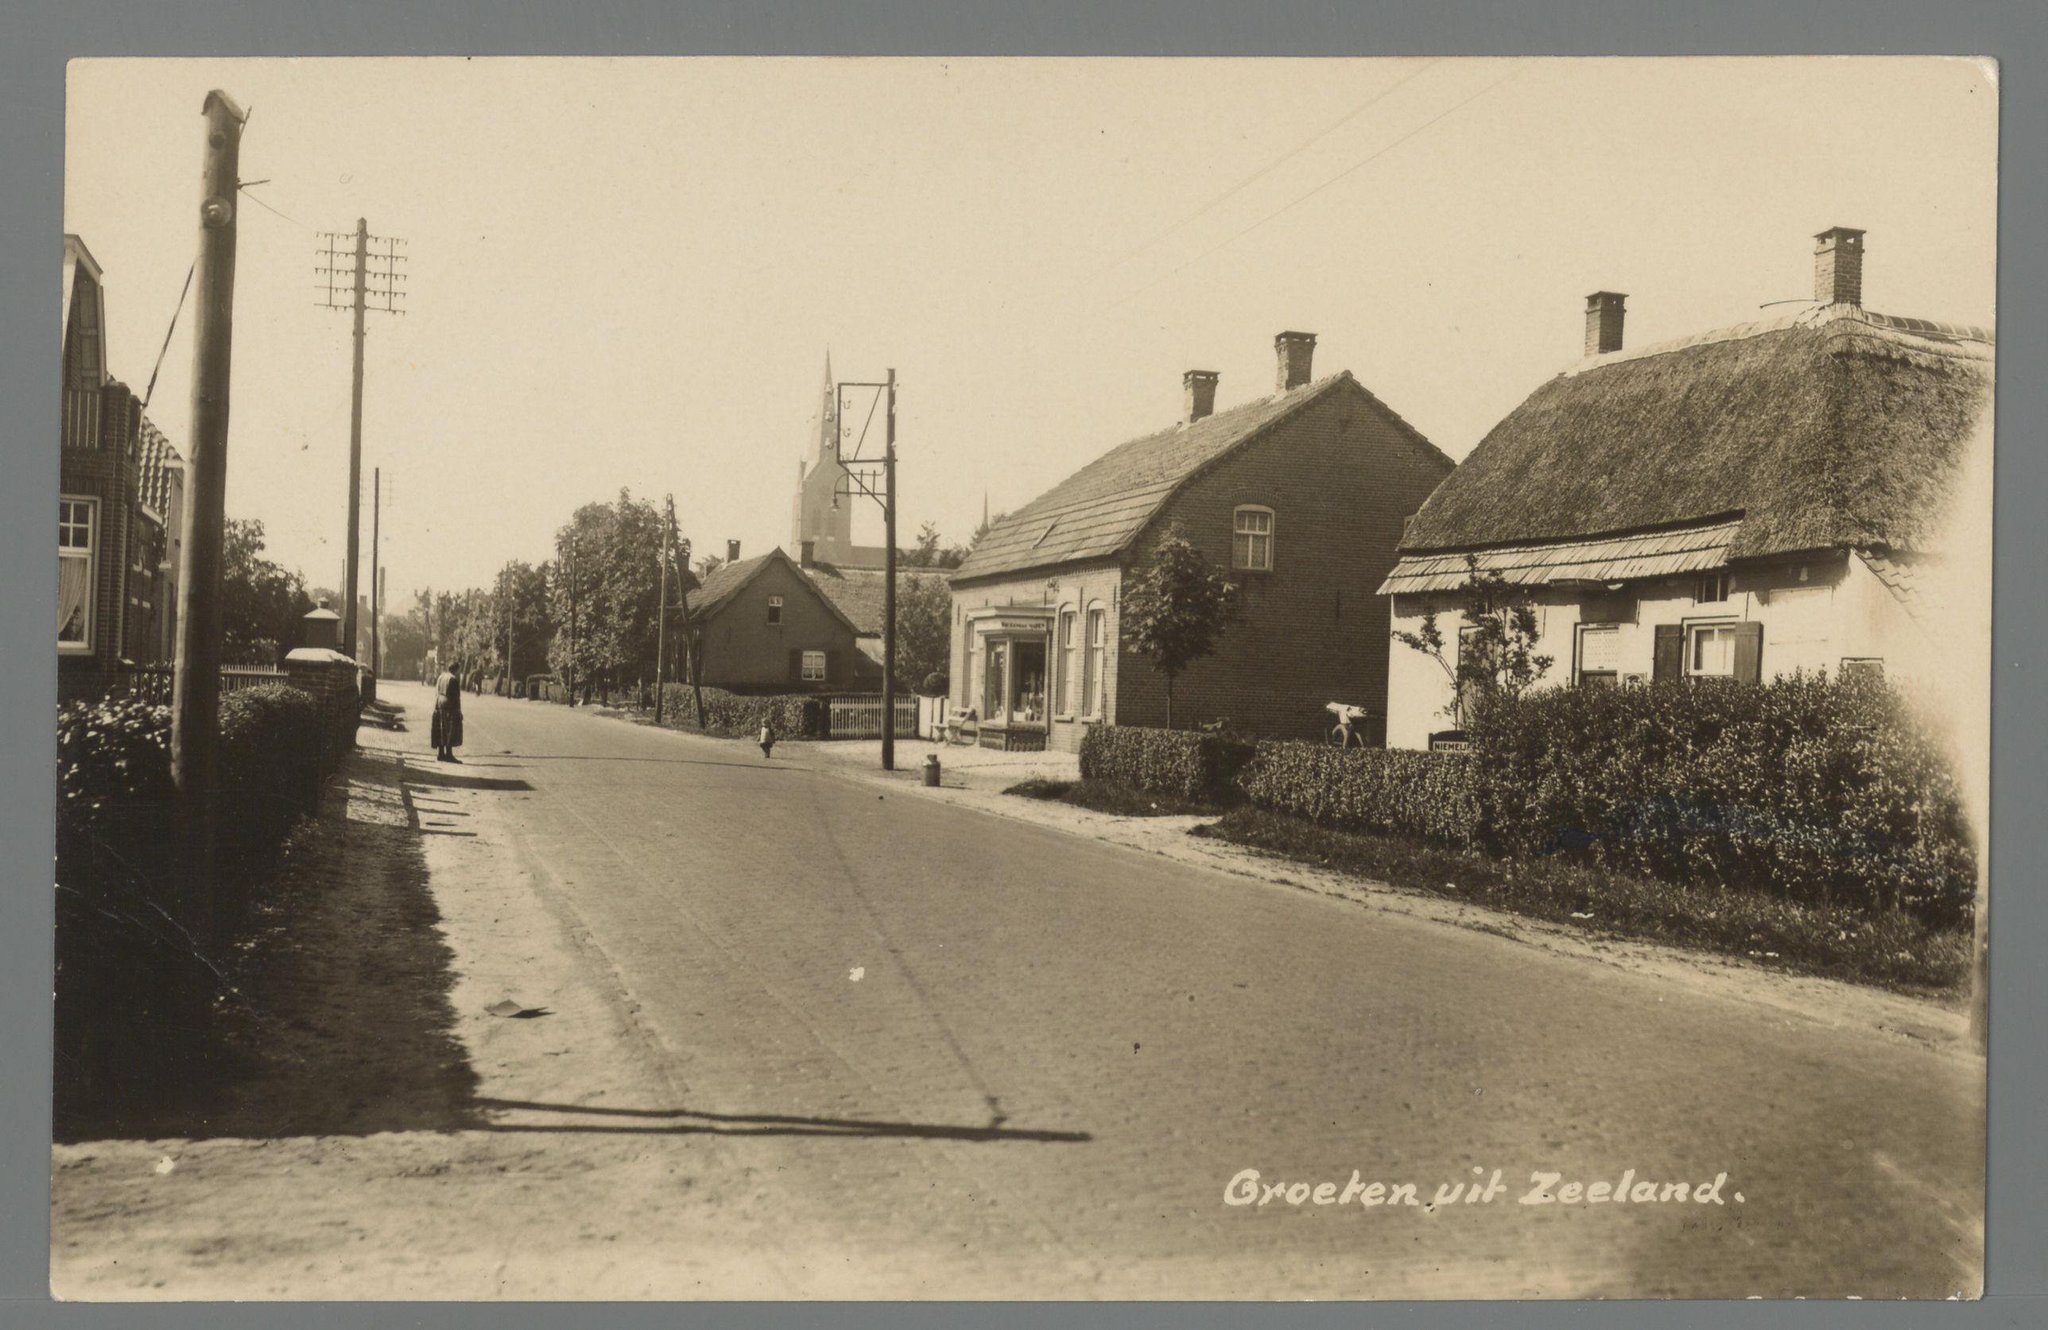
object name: ansichtkaart, prentbriefkaart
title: Groeten uit Zeeland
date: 1929-1937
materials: paper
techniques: gelatin silver print, writing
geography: arnhem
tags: street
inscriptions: postage stamp